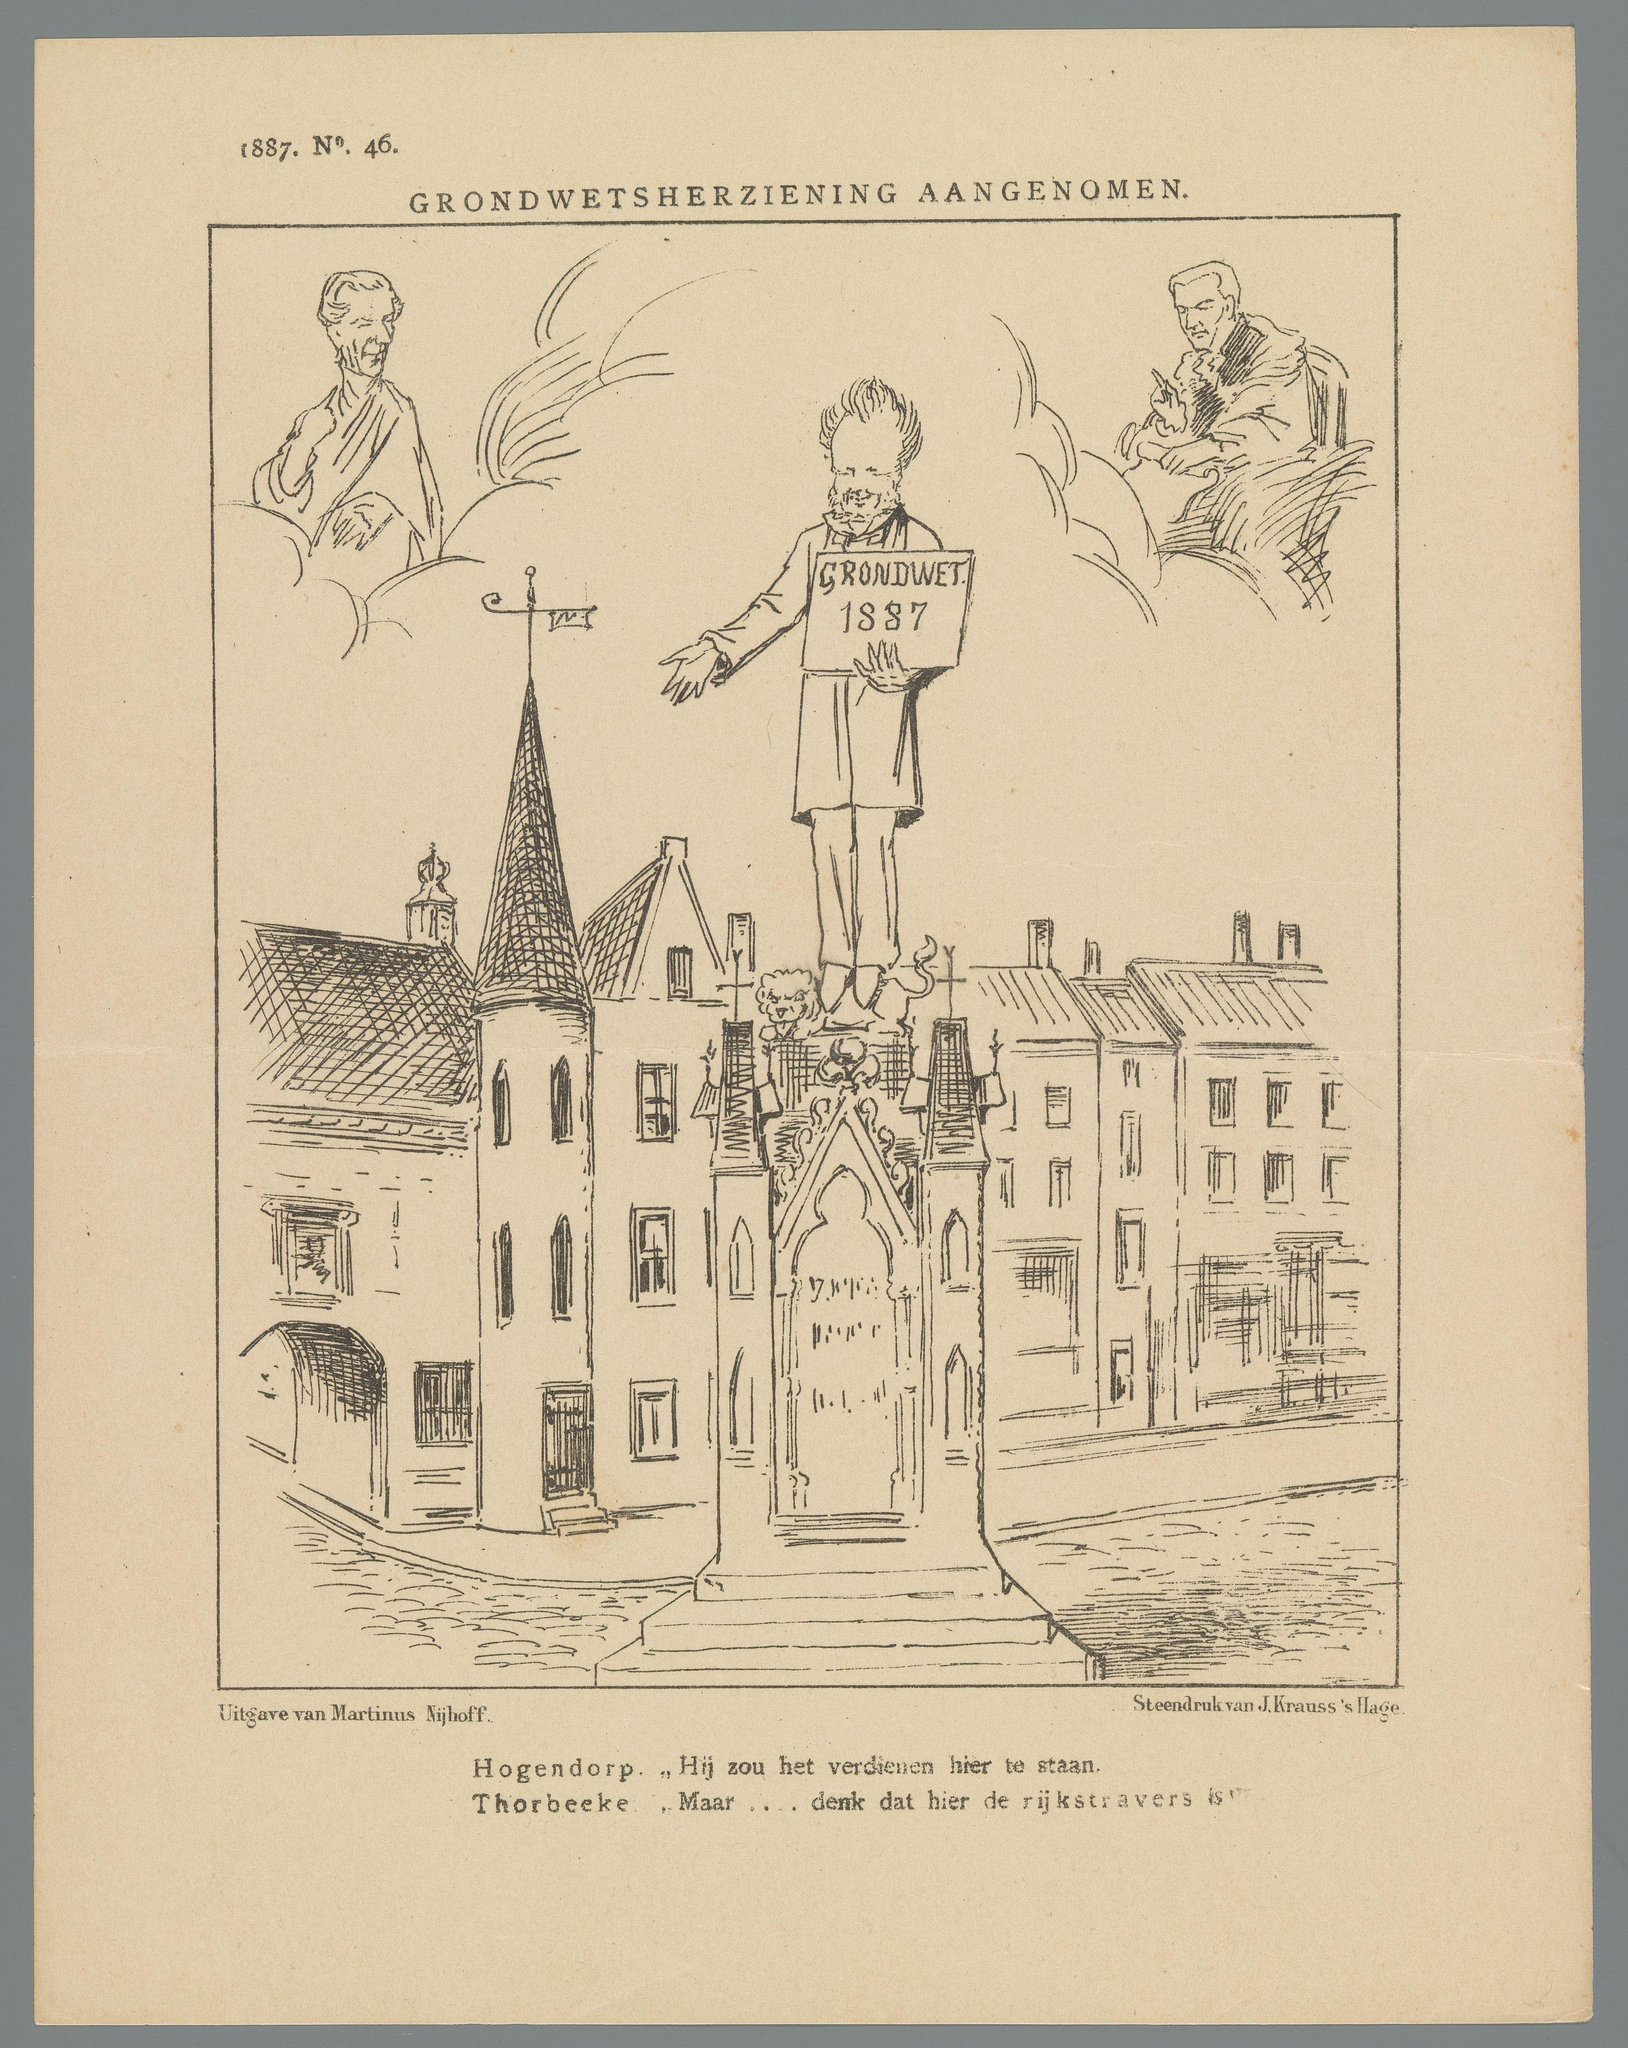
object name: print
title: Spotprent over het aannemen van de grondwetsherziening, 1887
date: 1887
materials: paper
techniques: lithograph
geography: the hague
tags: johan rudolf thorbecke, rotterdam, the hague, gijsbert karel graaf van hogendorp, amsterdam, politician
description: Spotprent over het aannemen van de grondwetsherziening. Vanuit de hemel zien Hogendorp en Thorbecke neer op Minister Heemskerk. Plaat verschenen bij het weekblad De Nederlandsche Spectator, nr. 46, 1887.